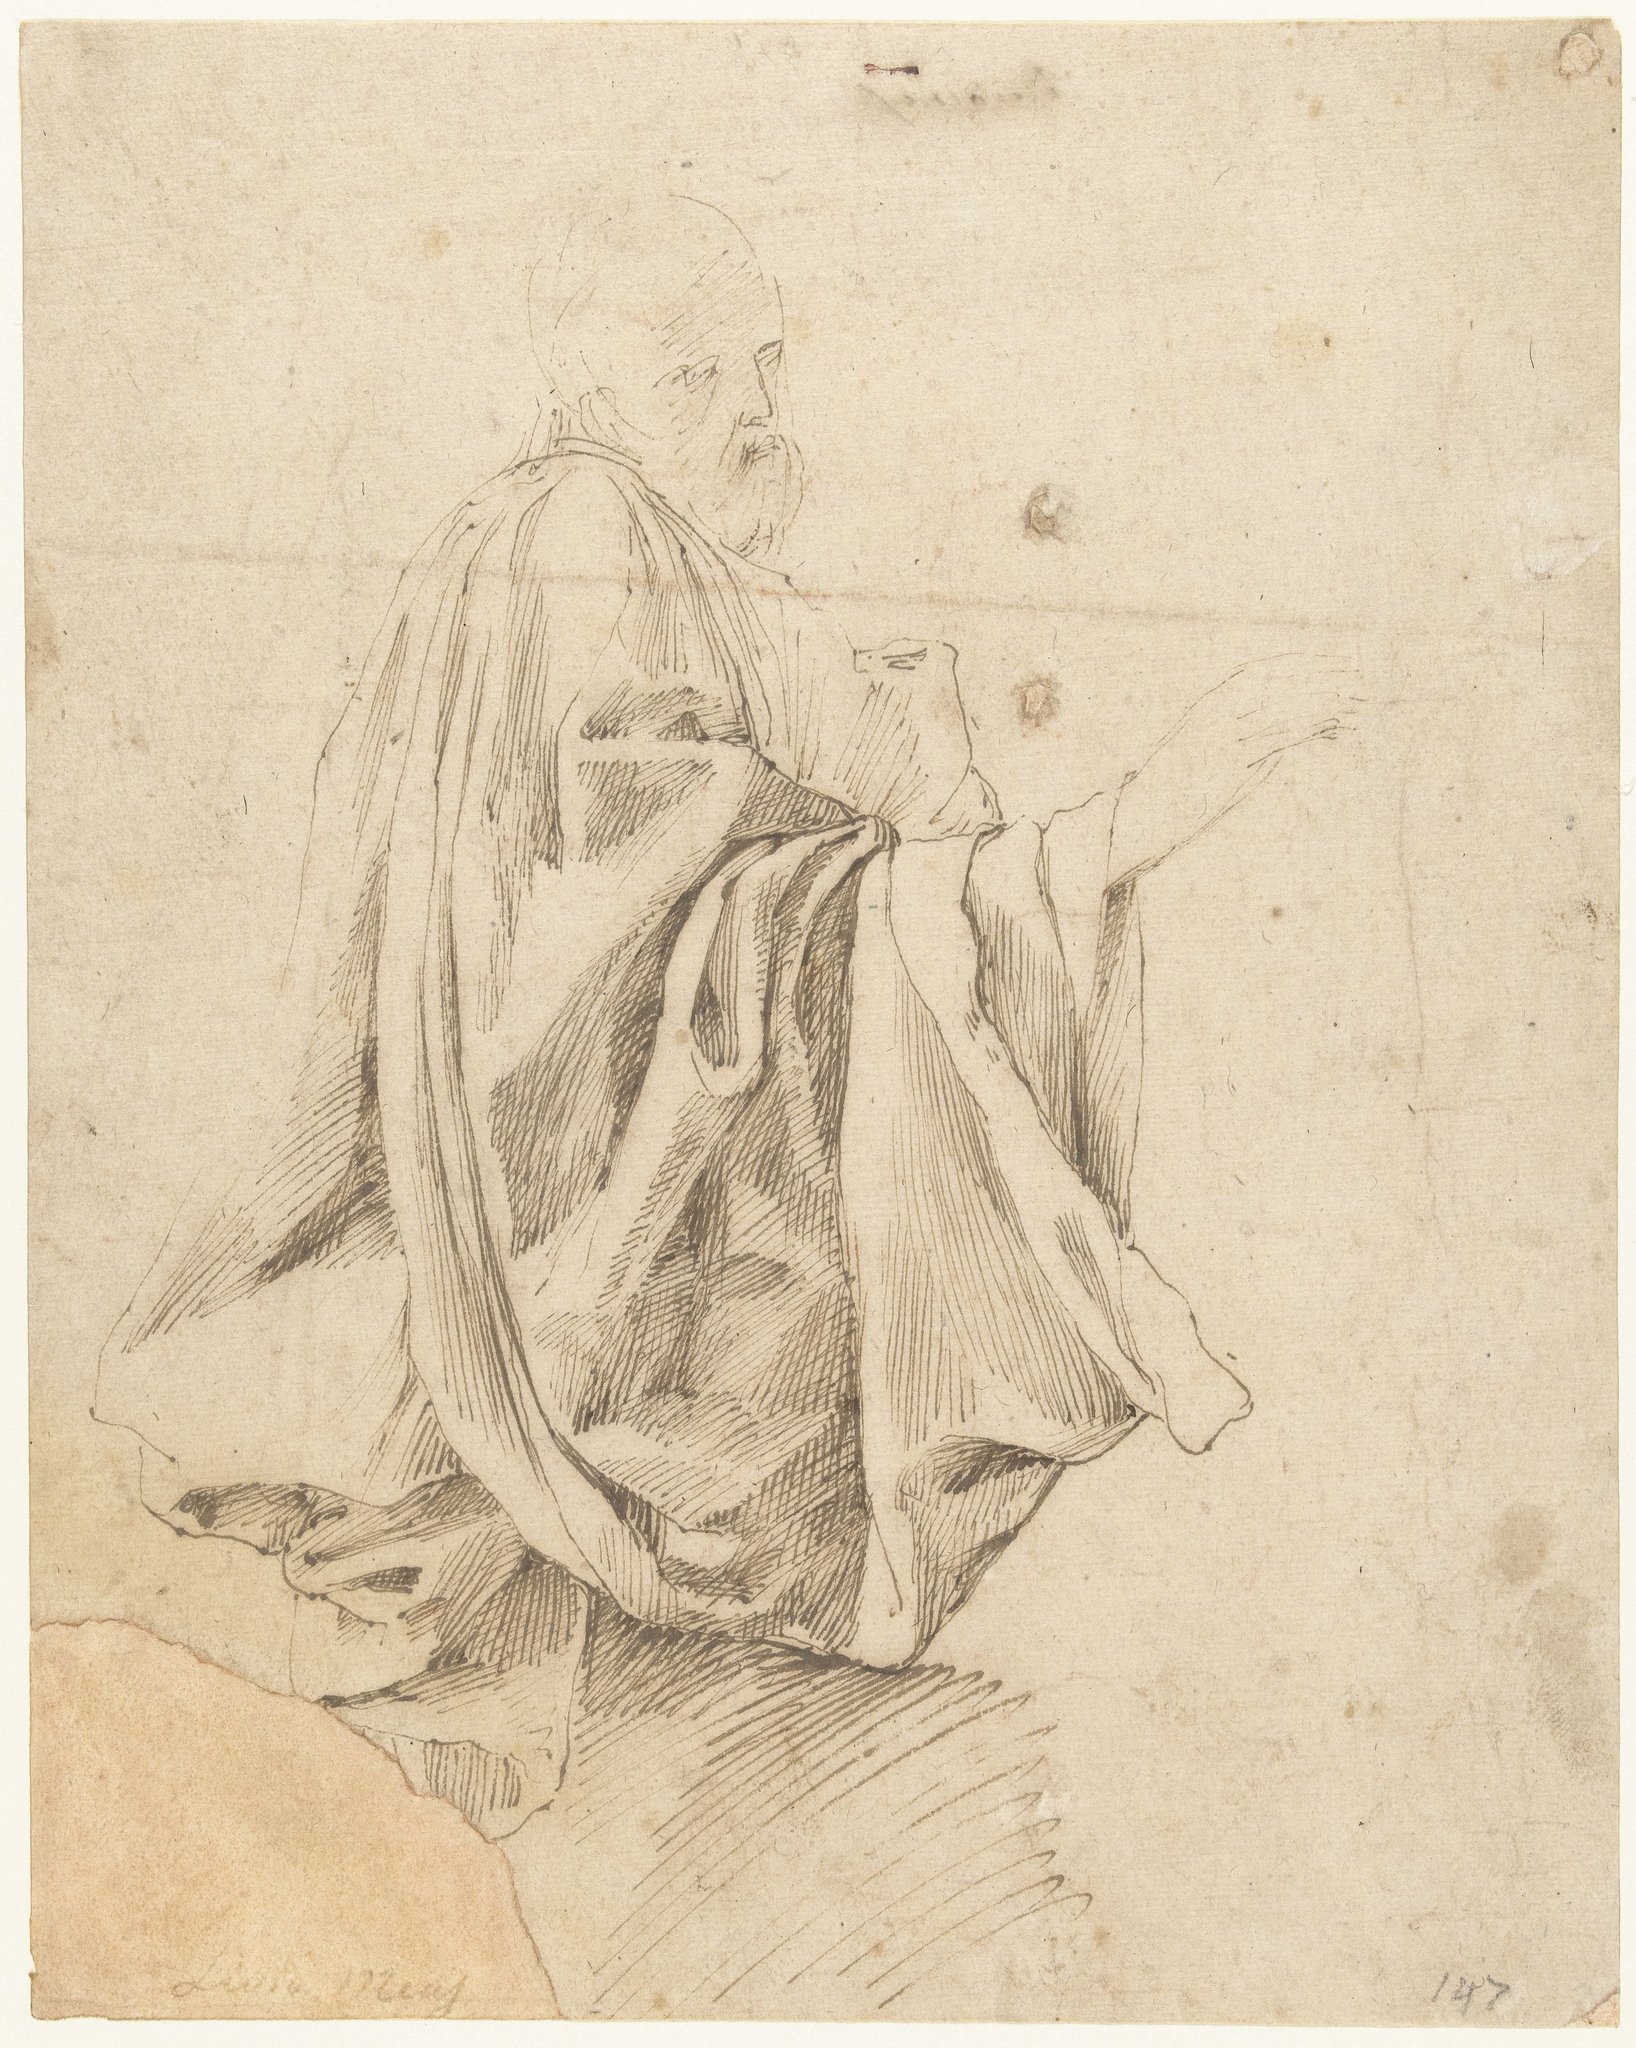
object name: drawing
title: Studie voor een knielende figuur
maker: lieven mehus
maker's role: draughtsman, print maker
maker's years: 1630-1691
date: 1640-1691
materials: ink, paper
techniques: pen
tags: kneeling figure, drapery, draped garment, 'gewandgebung'